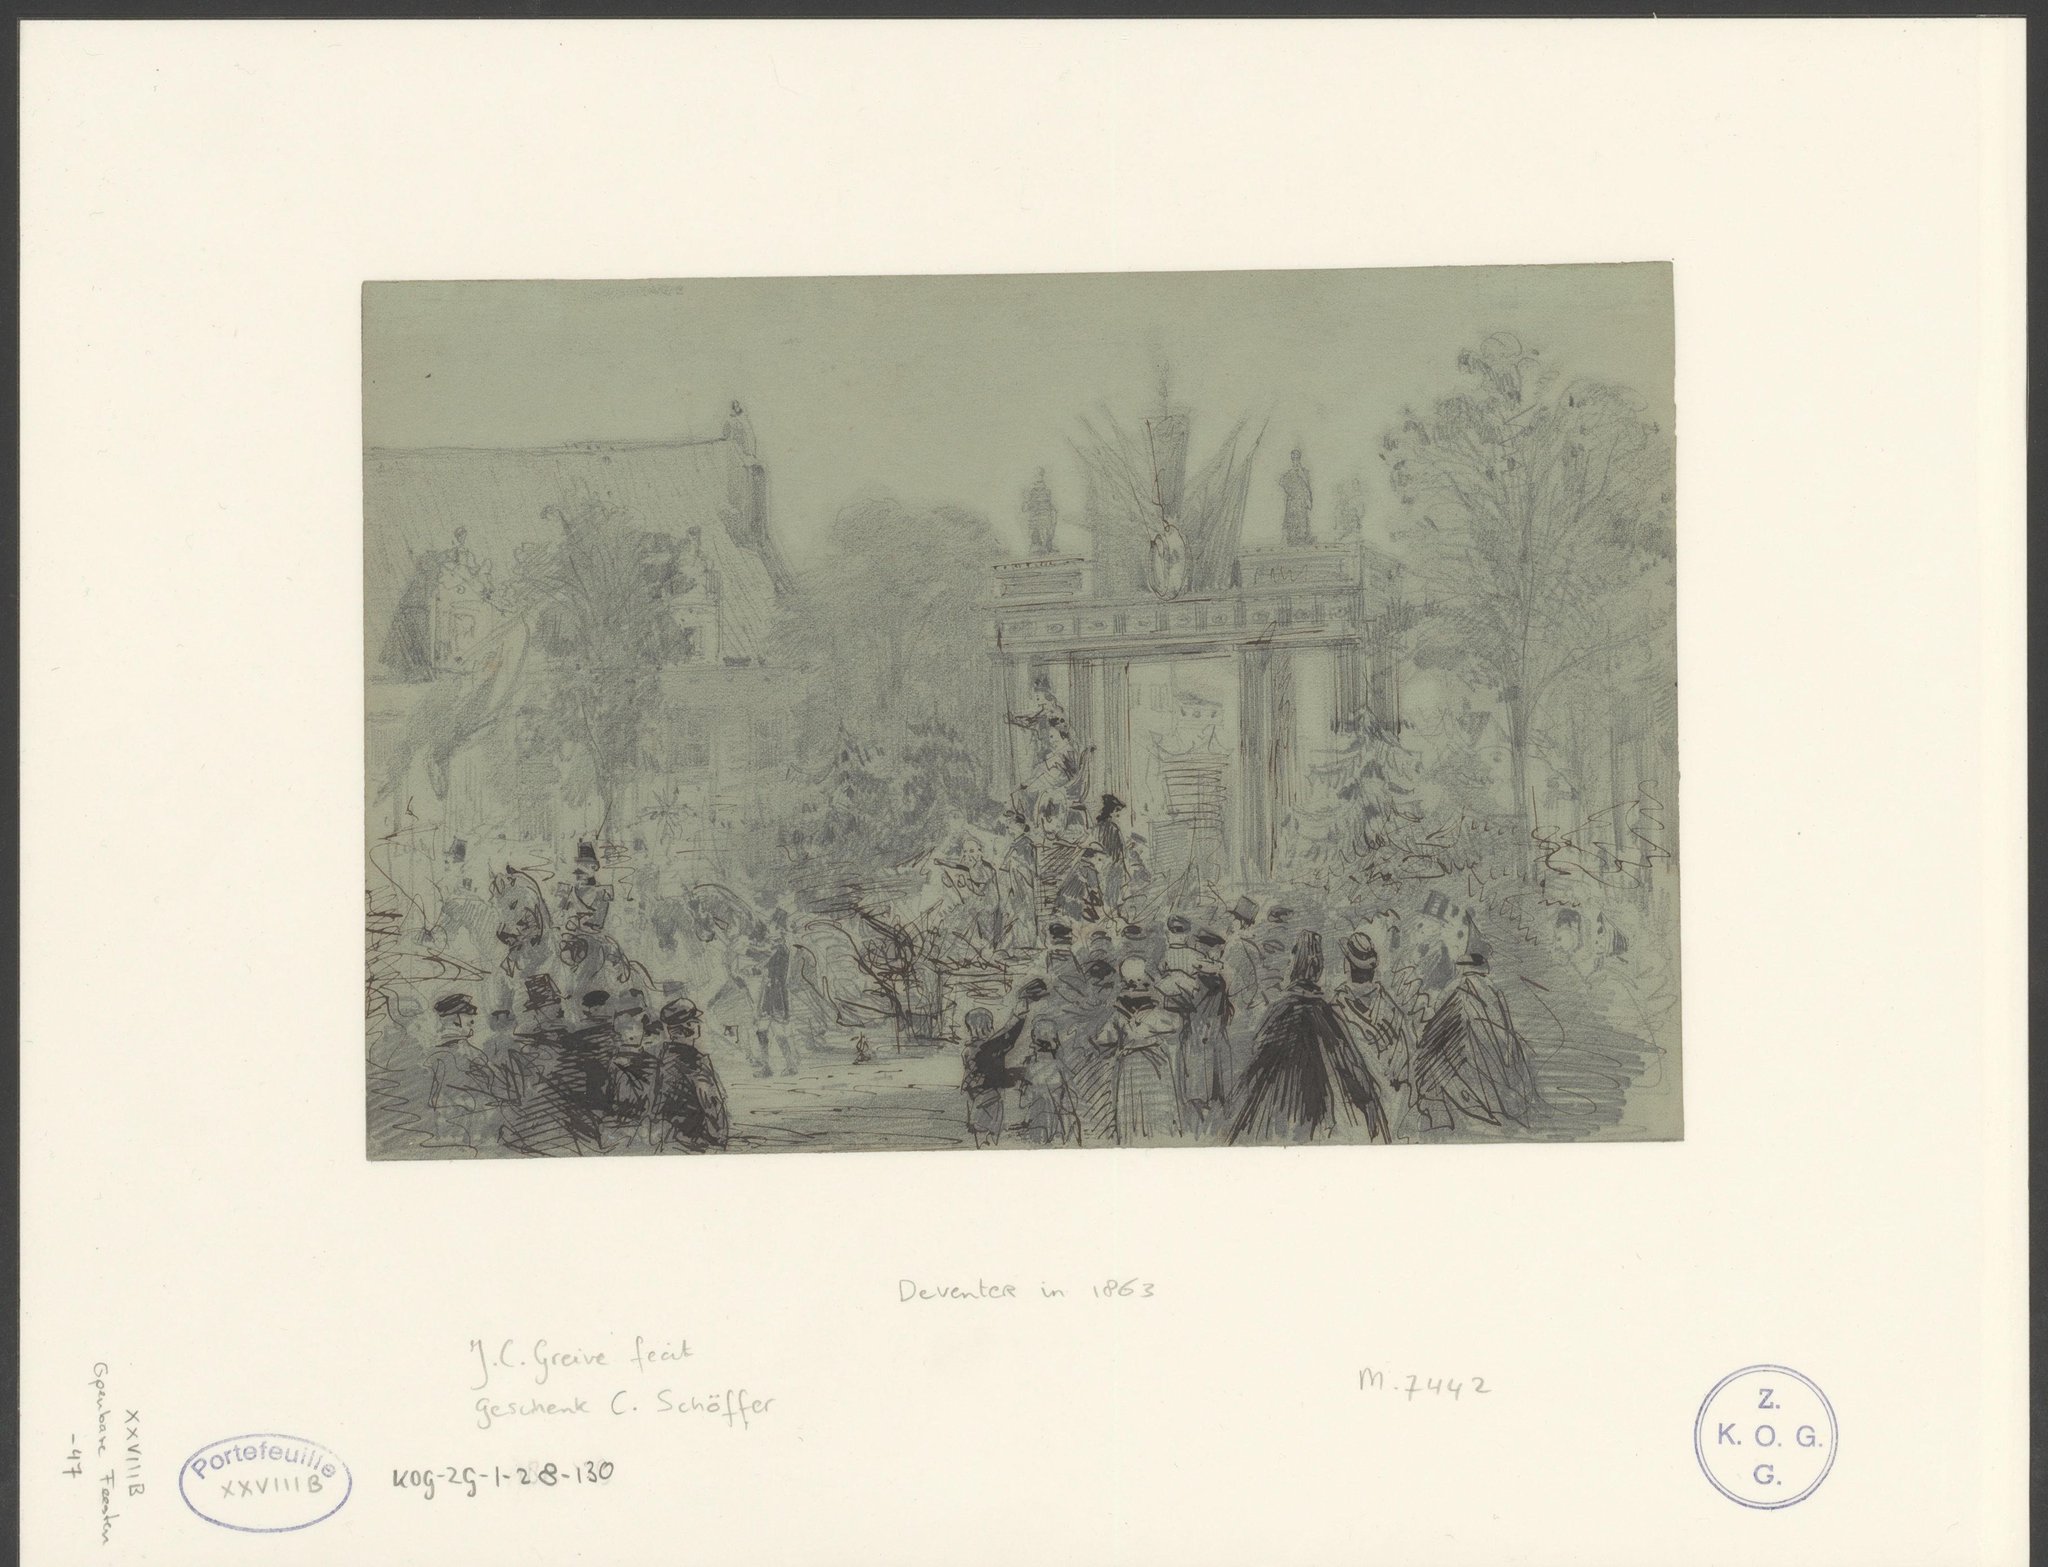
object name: drawing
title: Gezicht op de Bergpoort te Deventer, 1863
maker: johan conrad greive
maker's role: draughtsman, painter, print maker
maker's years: 1837-1891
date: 1863-1865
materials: ink, paper, pencil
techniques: pen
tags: triumphs (allegorical and symbolic), deventer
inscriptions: stamp, collector's mark: Lugt 1641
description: Onderwerpsrubrieken binnen de Atlas Zeden en Gewoonten: Zeden en Gewoonten in Engeren Zin. Volksleven. Openbare feesten. Vorstelijke intochten, (Illuminaties, vuurwerken en dergelijke, openbare feesten).